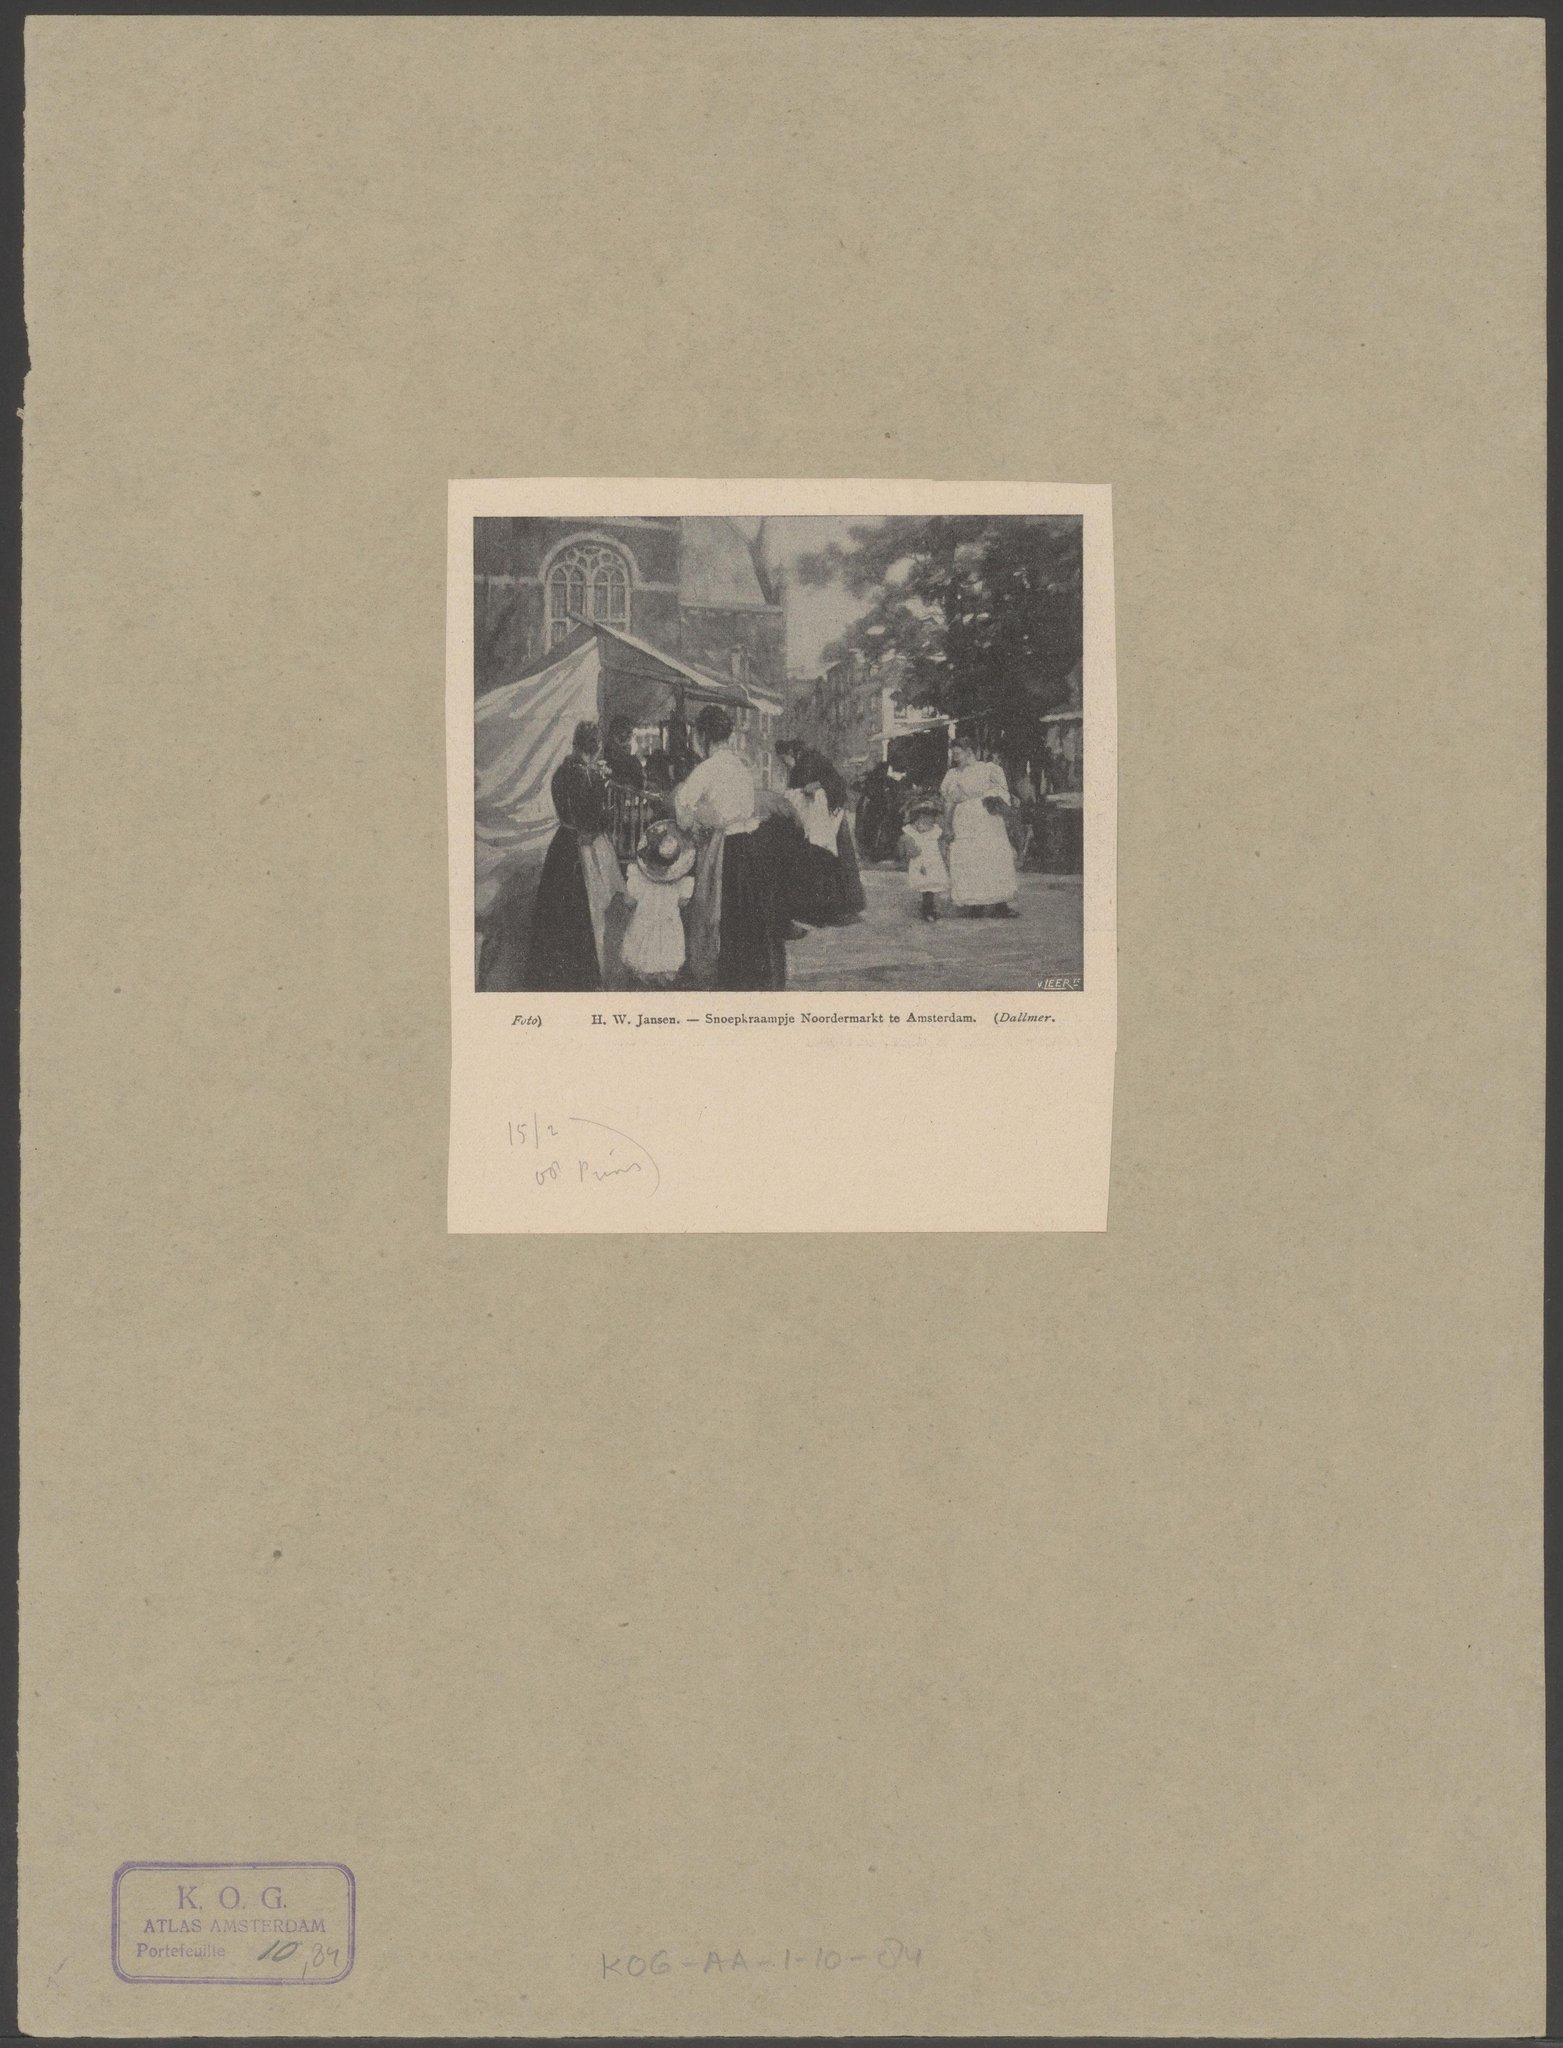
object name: photomechanical print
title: Gezicht op een snoepkraam op de Noordermarkt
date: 1908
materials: paper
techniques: letterpress printing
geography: amsterdam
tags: square, place, circus, etc., city-view in general; 'veduta', stall, booth (~ market), market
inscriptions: collector's mark: ‘10,84’ Lugt 1641b, name: ‘Dallmer’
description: Onderwerpsrubriek binnen de Atlas Amsterdam: Nieuwmarkt, Noordermarkt.